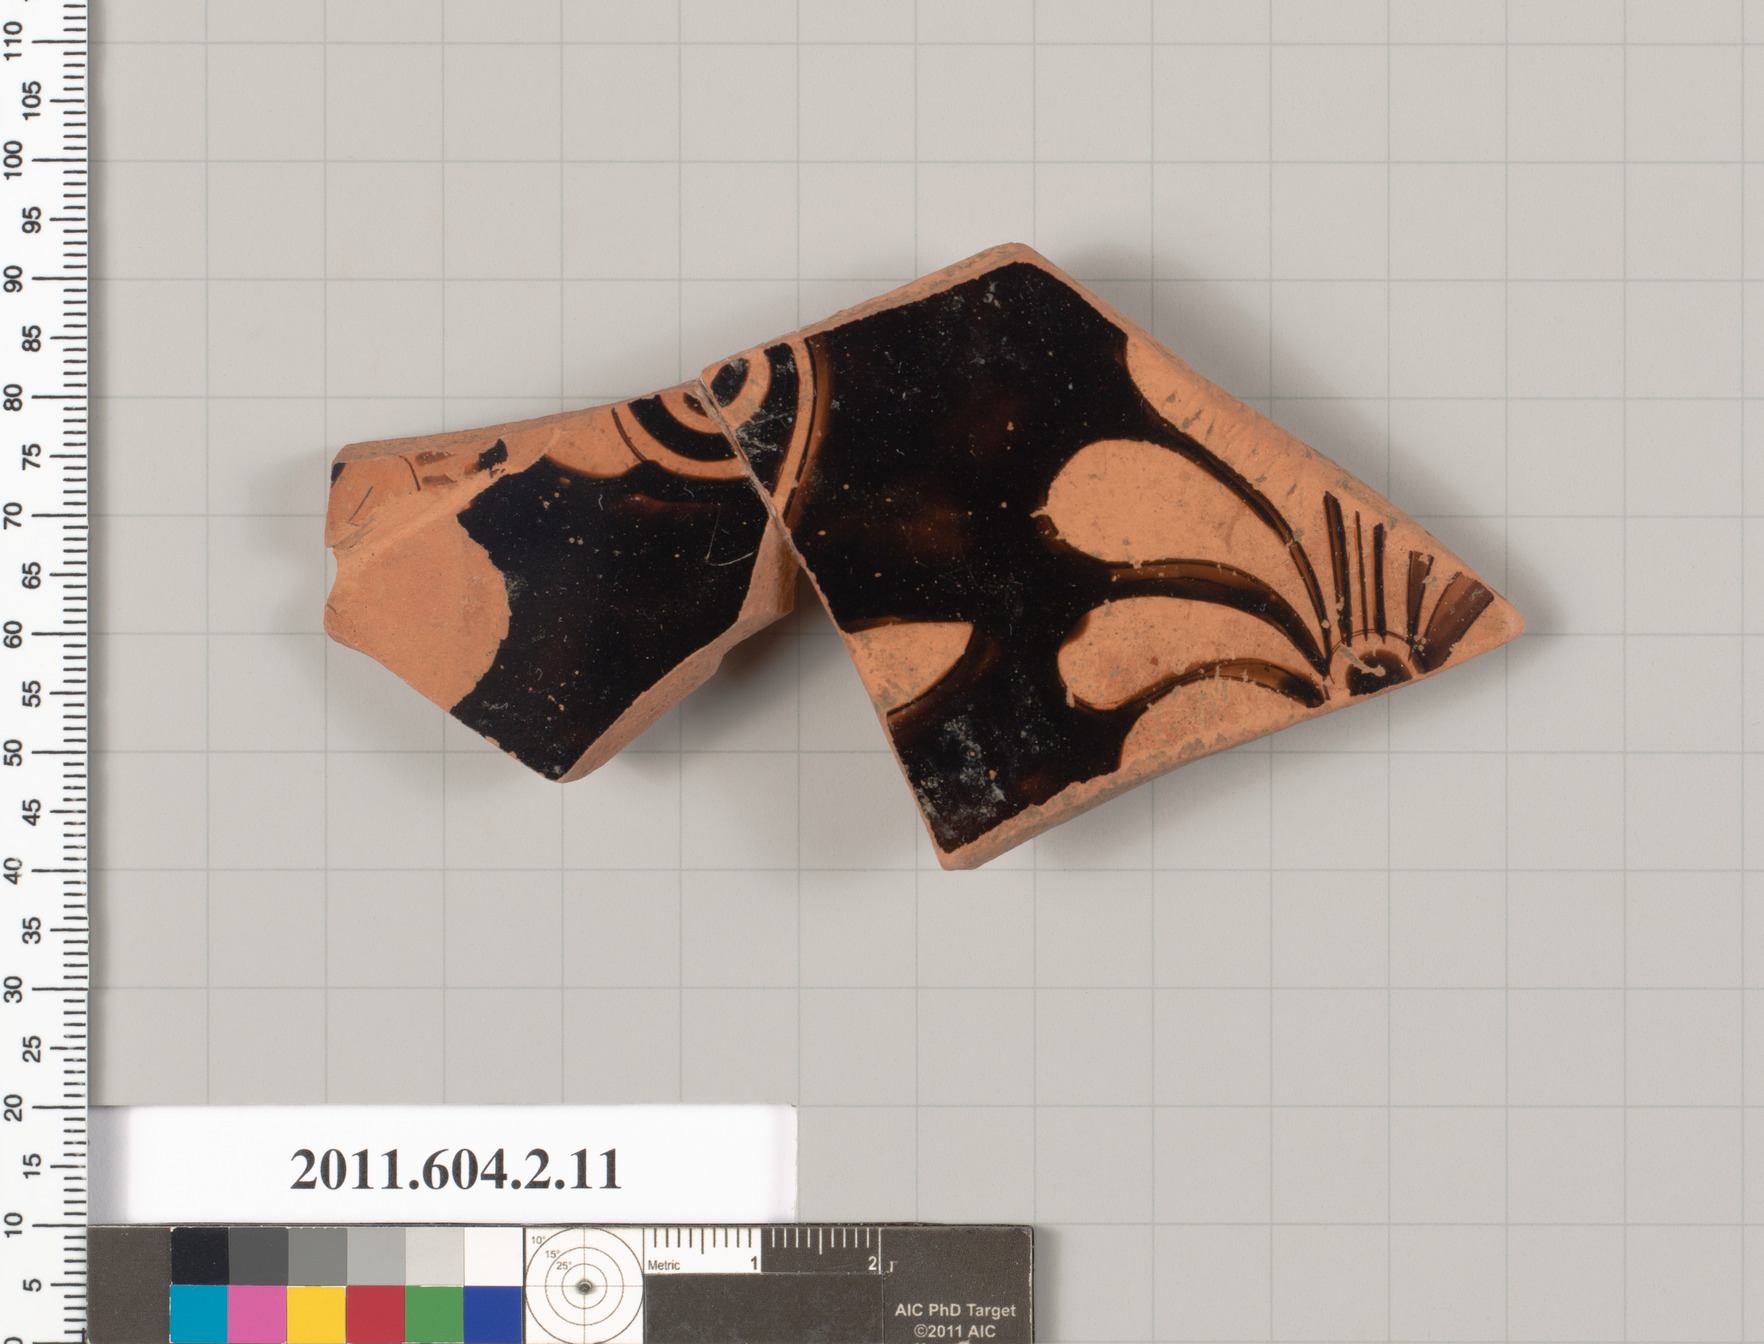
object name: neck amphora fragment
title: Terracotta fragment of a neck-amphora (jar)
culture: greek, attic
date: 460-450 BCE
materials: terracotta